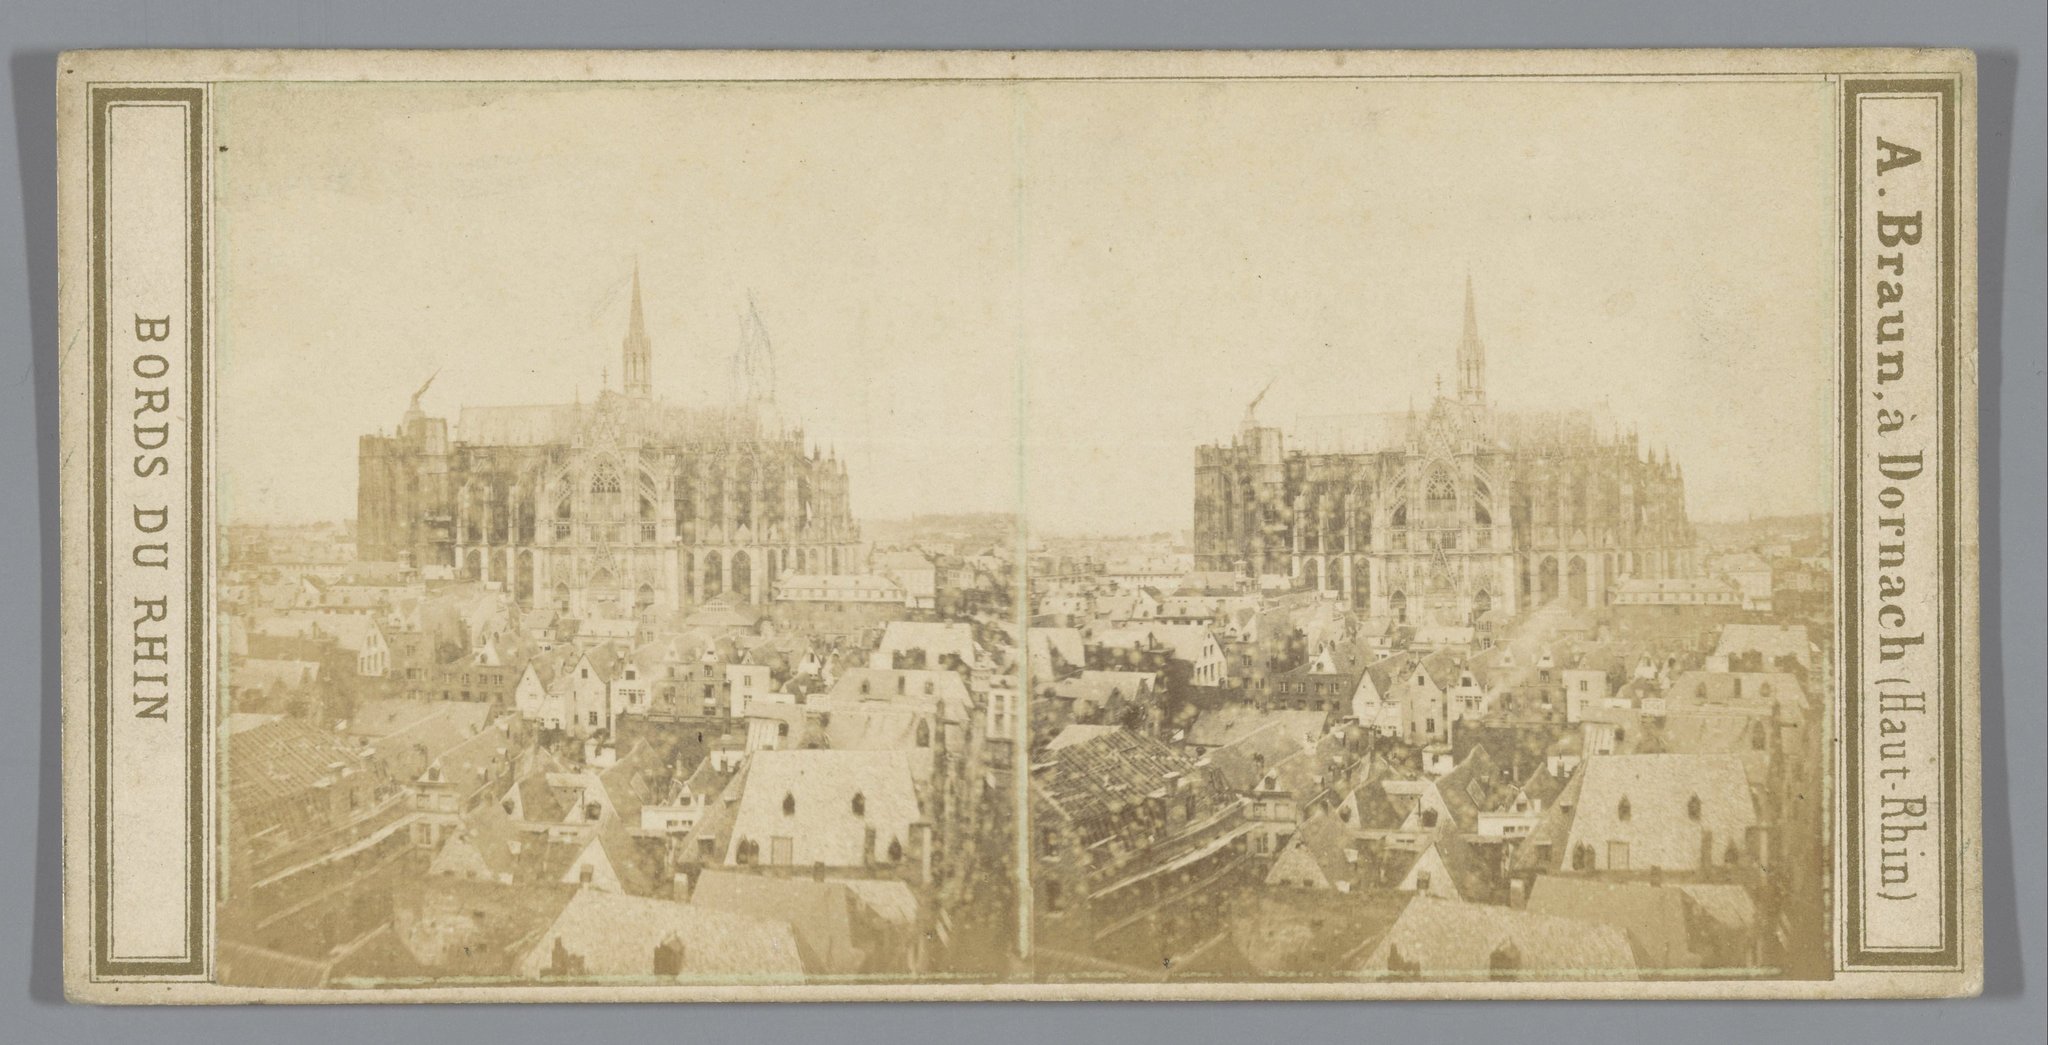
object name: stereograph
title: Cathédrale de Cologne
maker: Anonymous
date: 1863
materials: cardboard, paper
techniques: albumen print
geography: cologne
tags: city-view in general; 'veduta', roman catholic church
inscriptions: number: ‘2647’